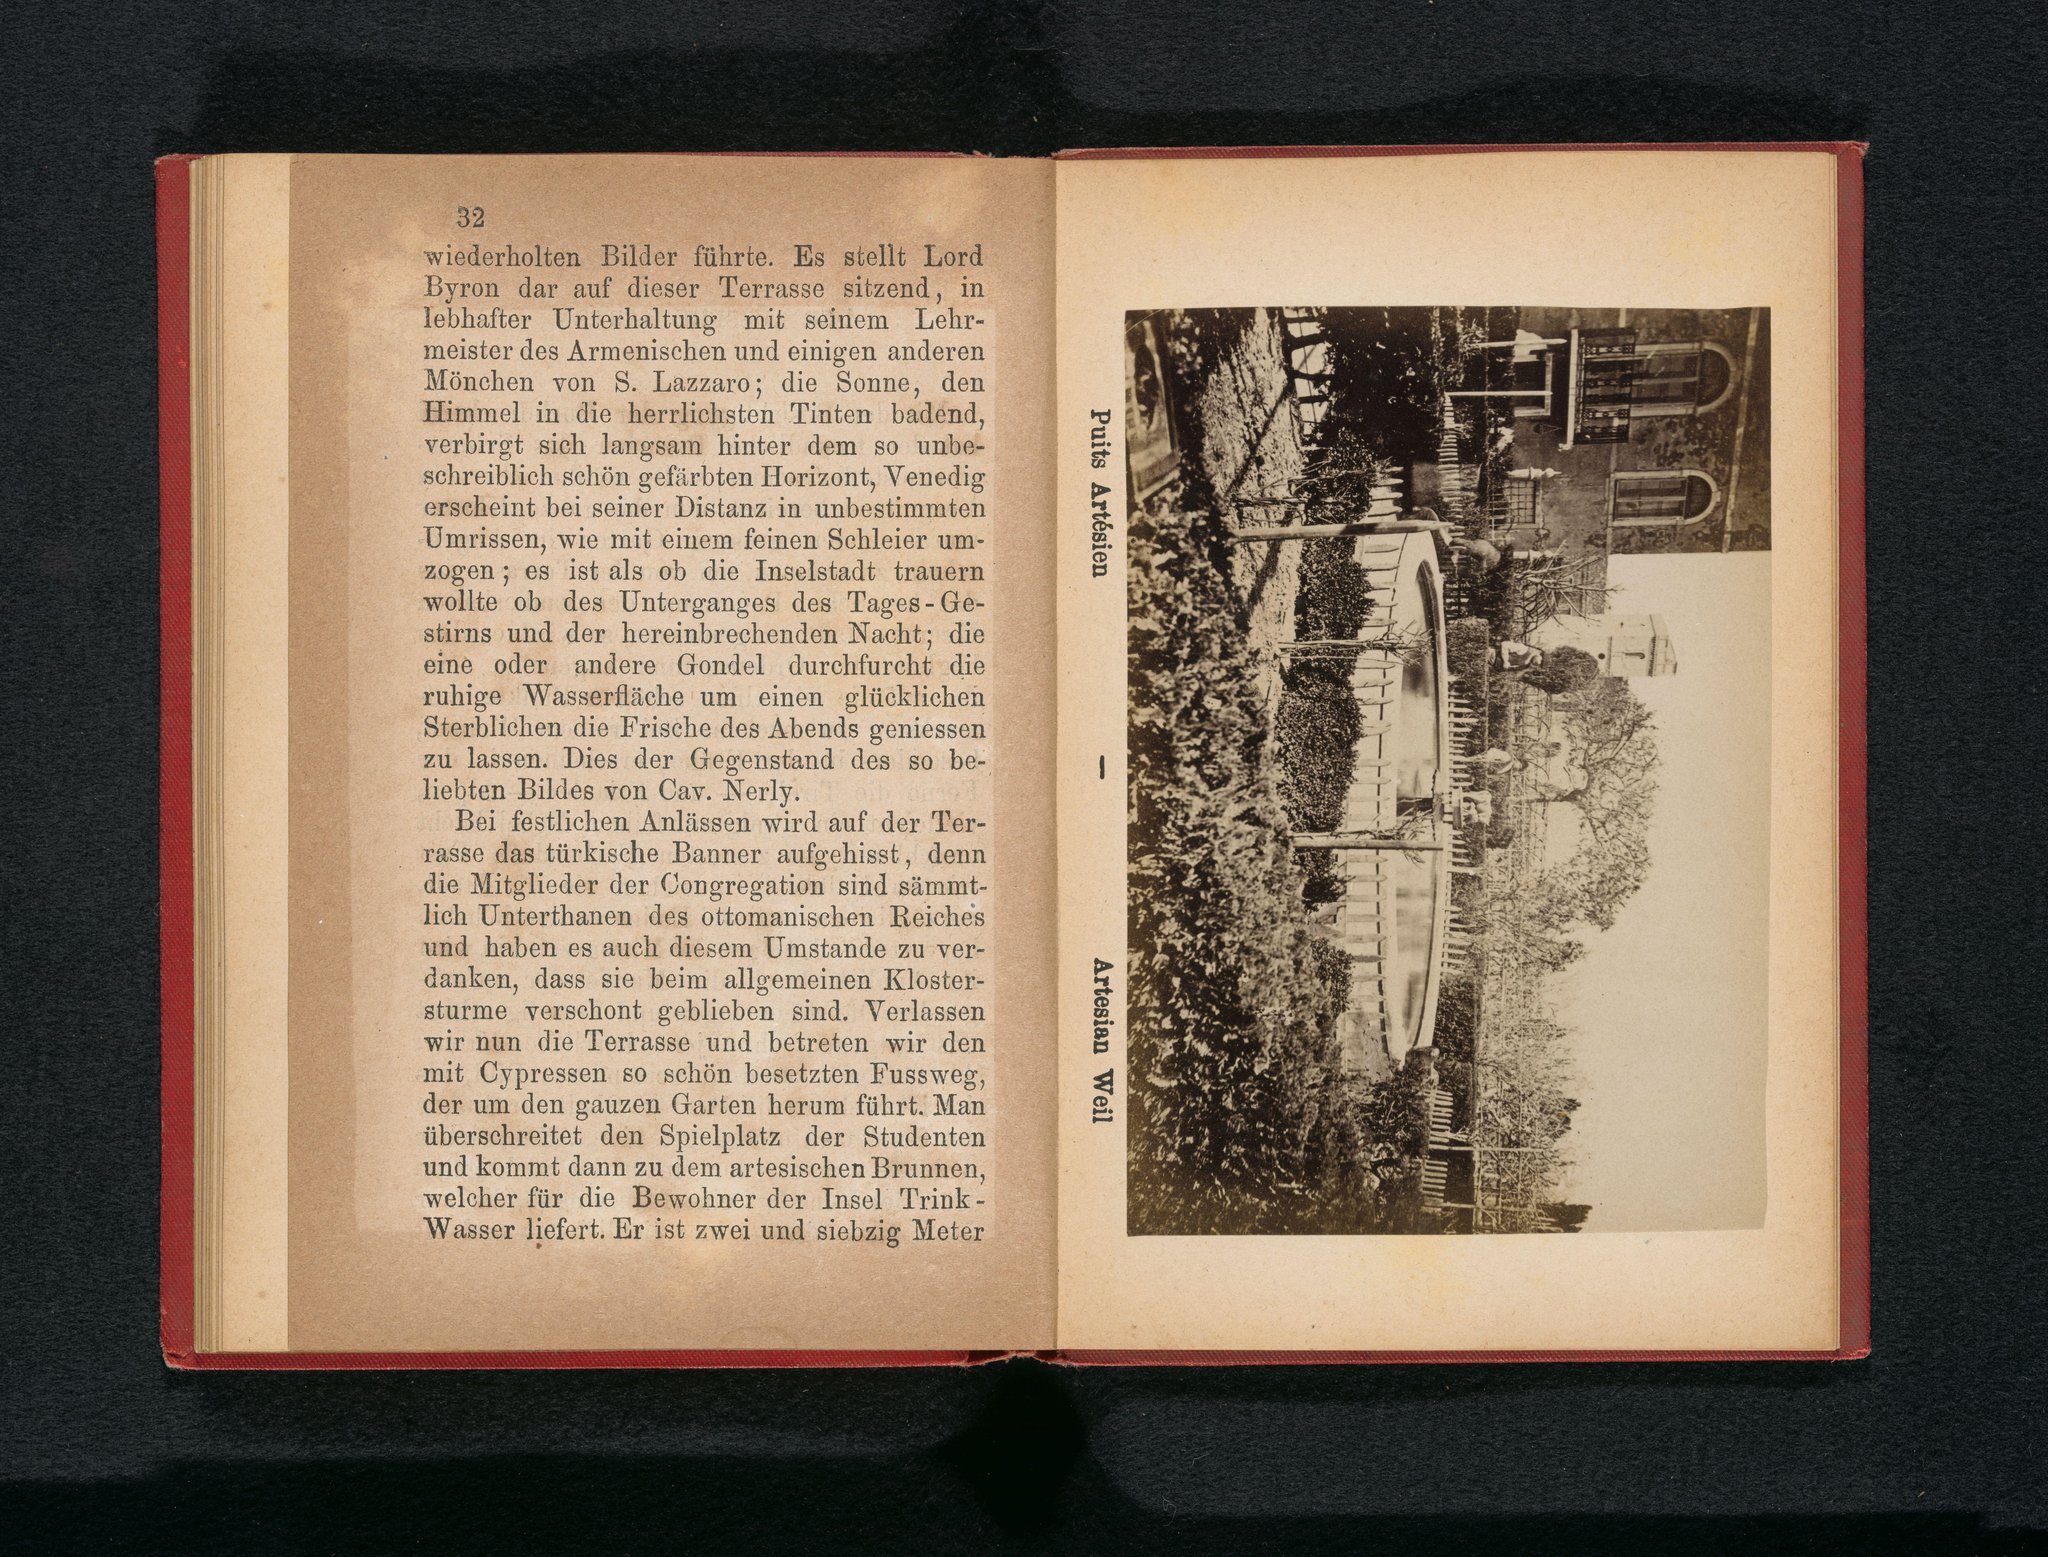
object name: page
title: Artesian well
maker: Anonymous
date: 1870-1880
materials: paper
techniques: albumen print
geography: san lazzaro degli armeni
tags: well